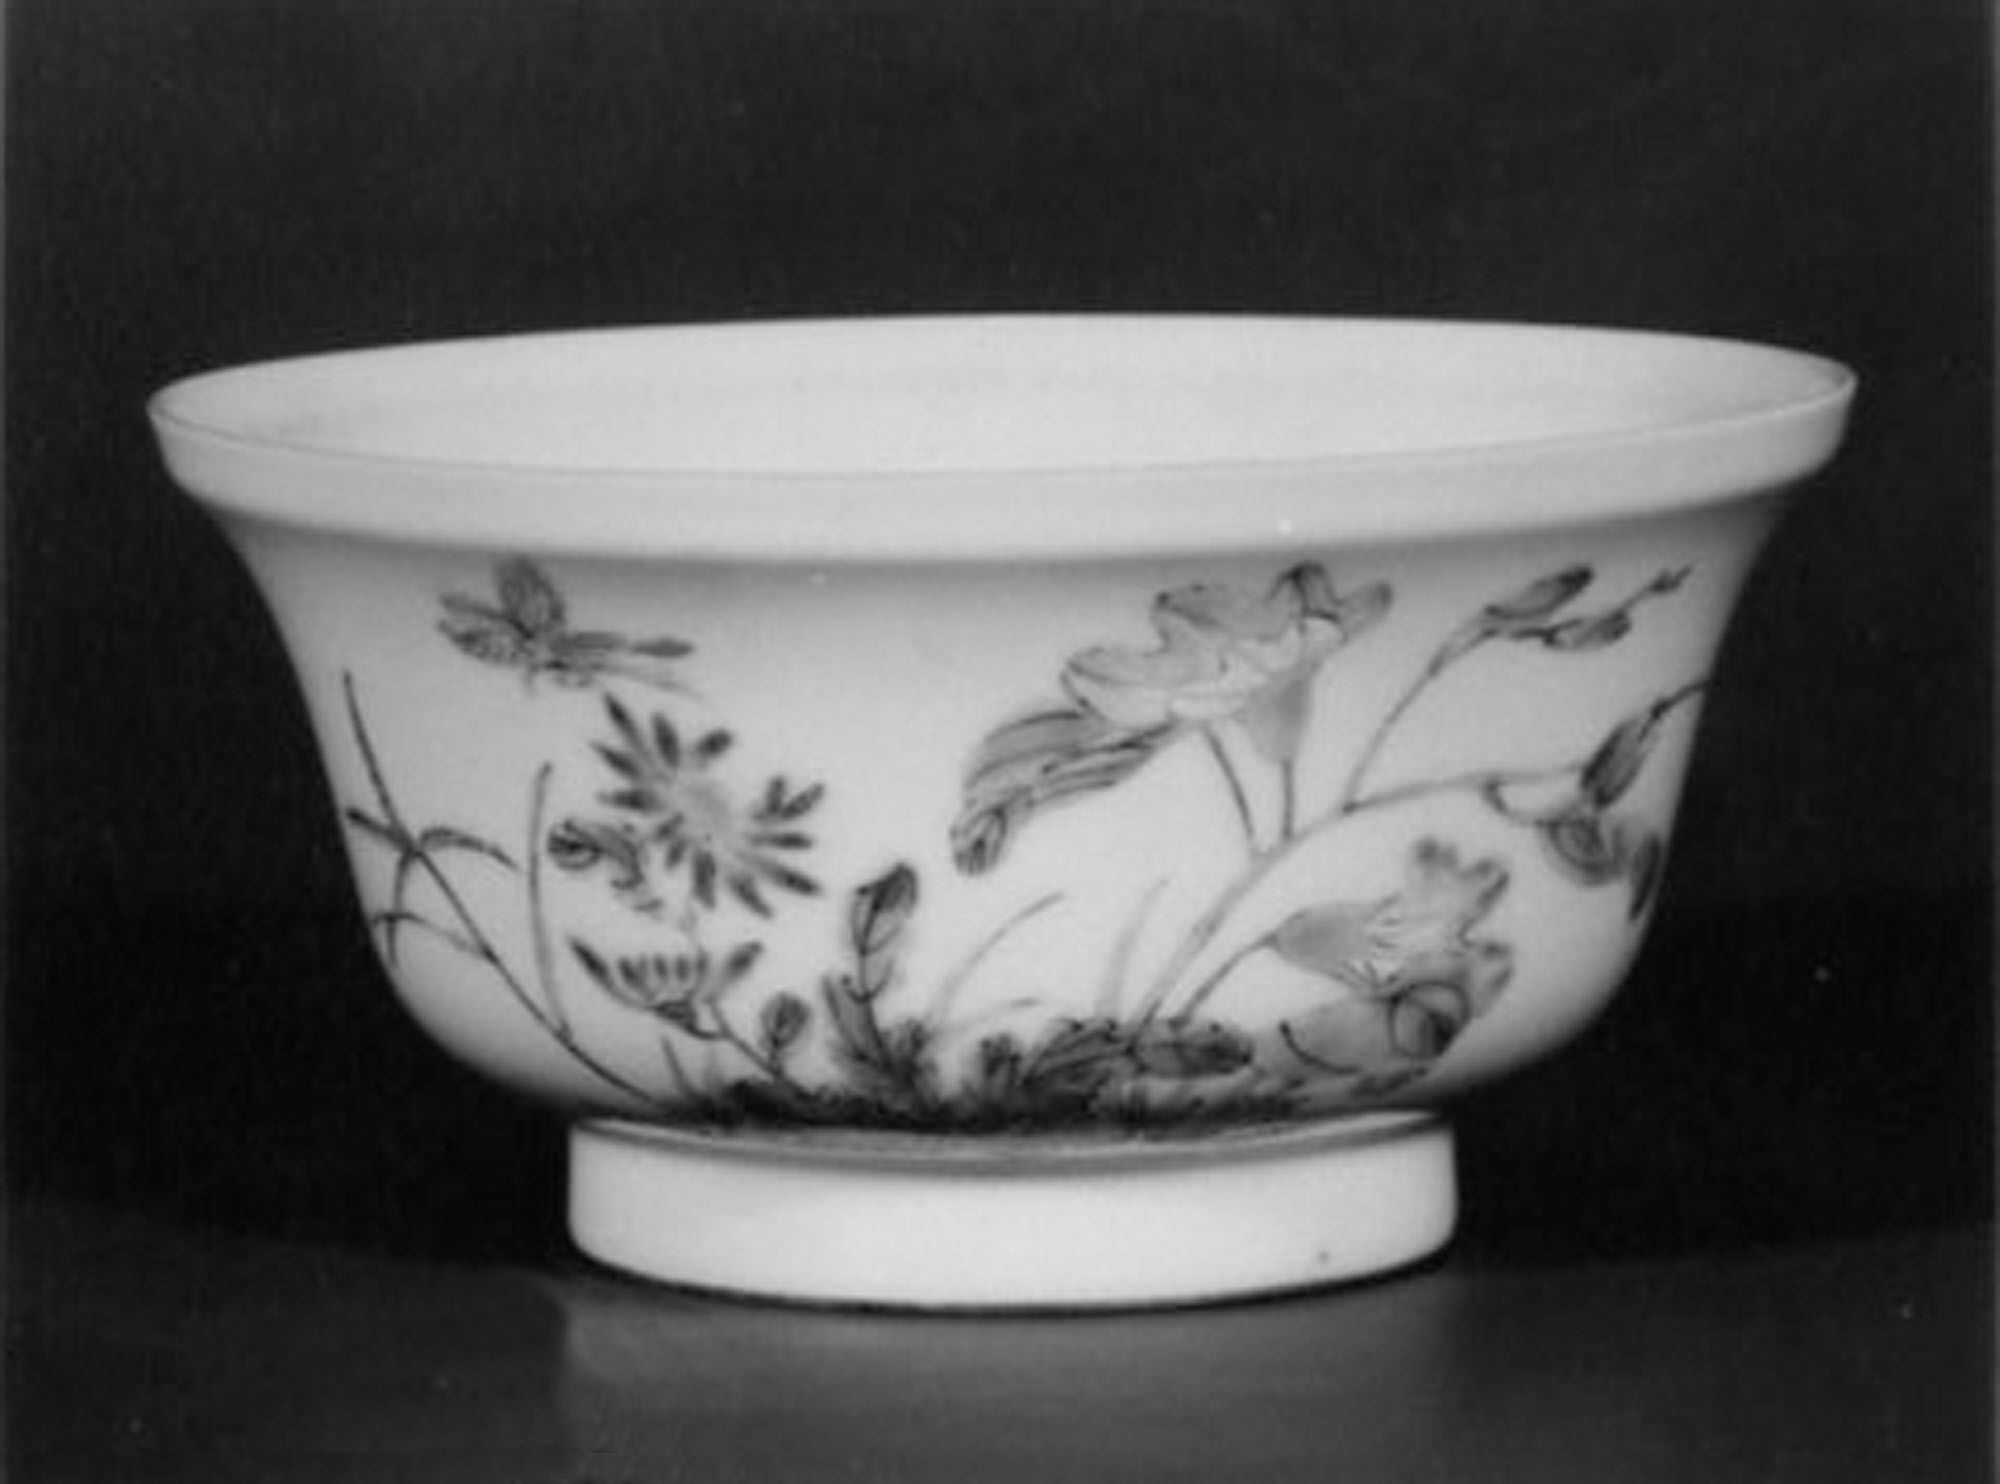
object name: bowl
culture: chinese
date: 1723-1735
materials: enamel, porcelain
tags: flowers